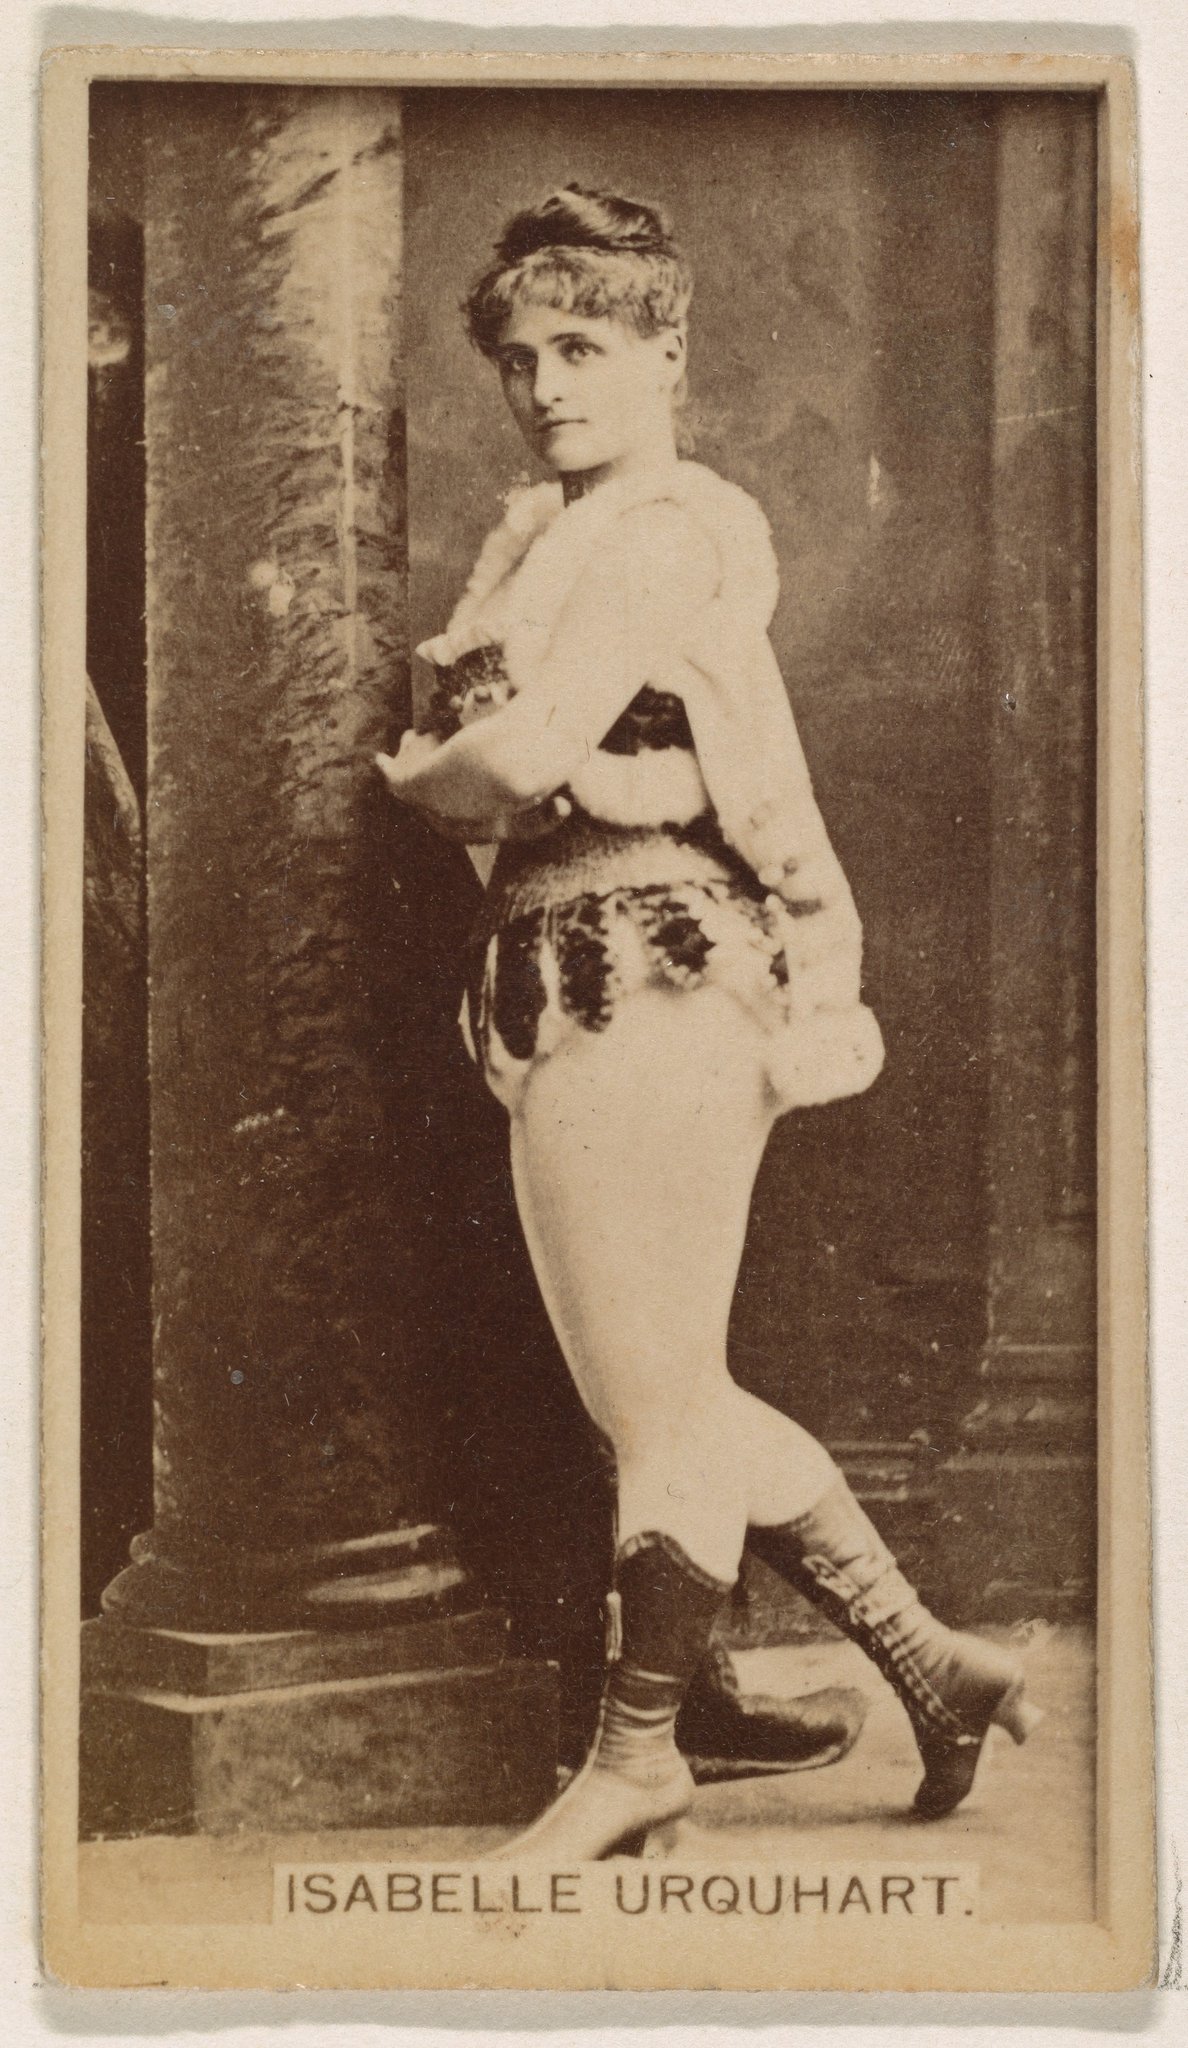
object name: photograph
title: Isabelle Urquhart, from the Actresses series (N245) issued by Kinney Brothers to promote Sweet Caporal Cigarettes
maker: kinney brothers tobacco company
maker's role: publisher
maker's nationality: american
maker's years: 1869-2011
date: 1890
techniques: albumen silver print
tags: portraits,women,actresses